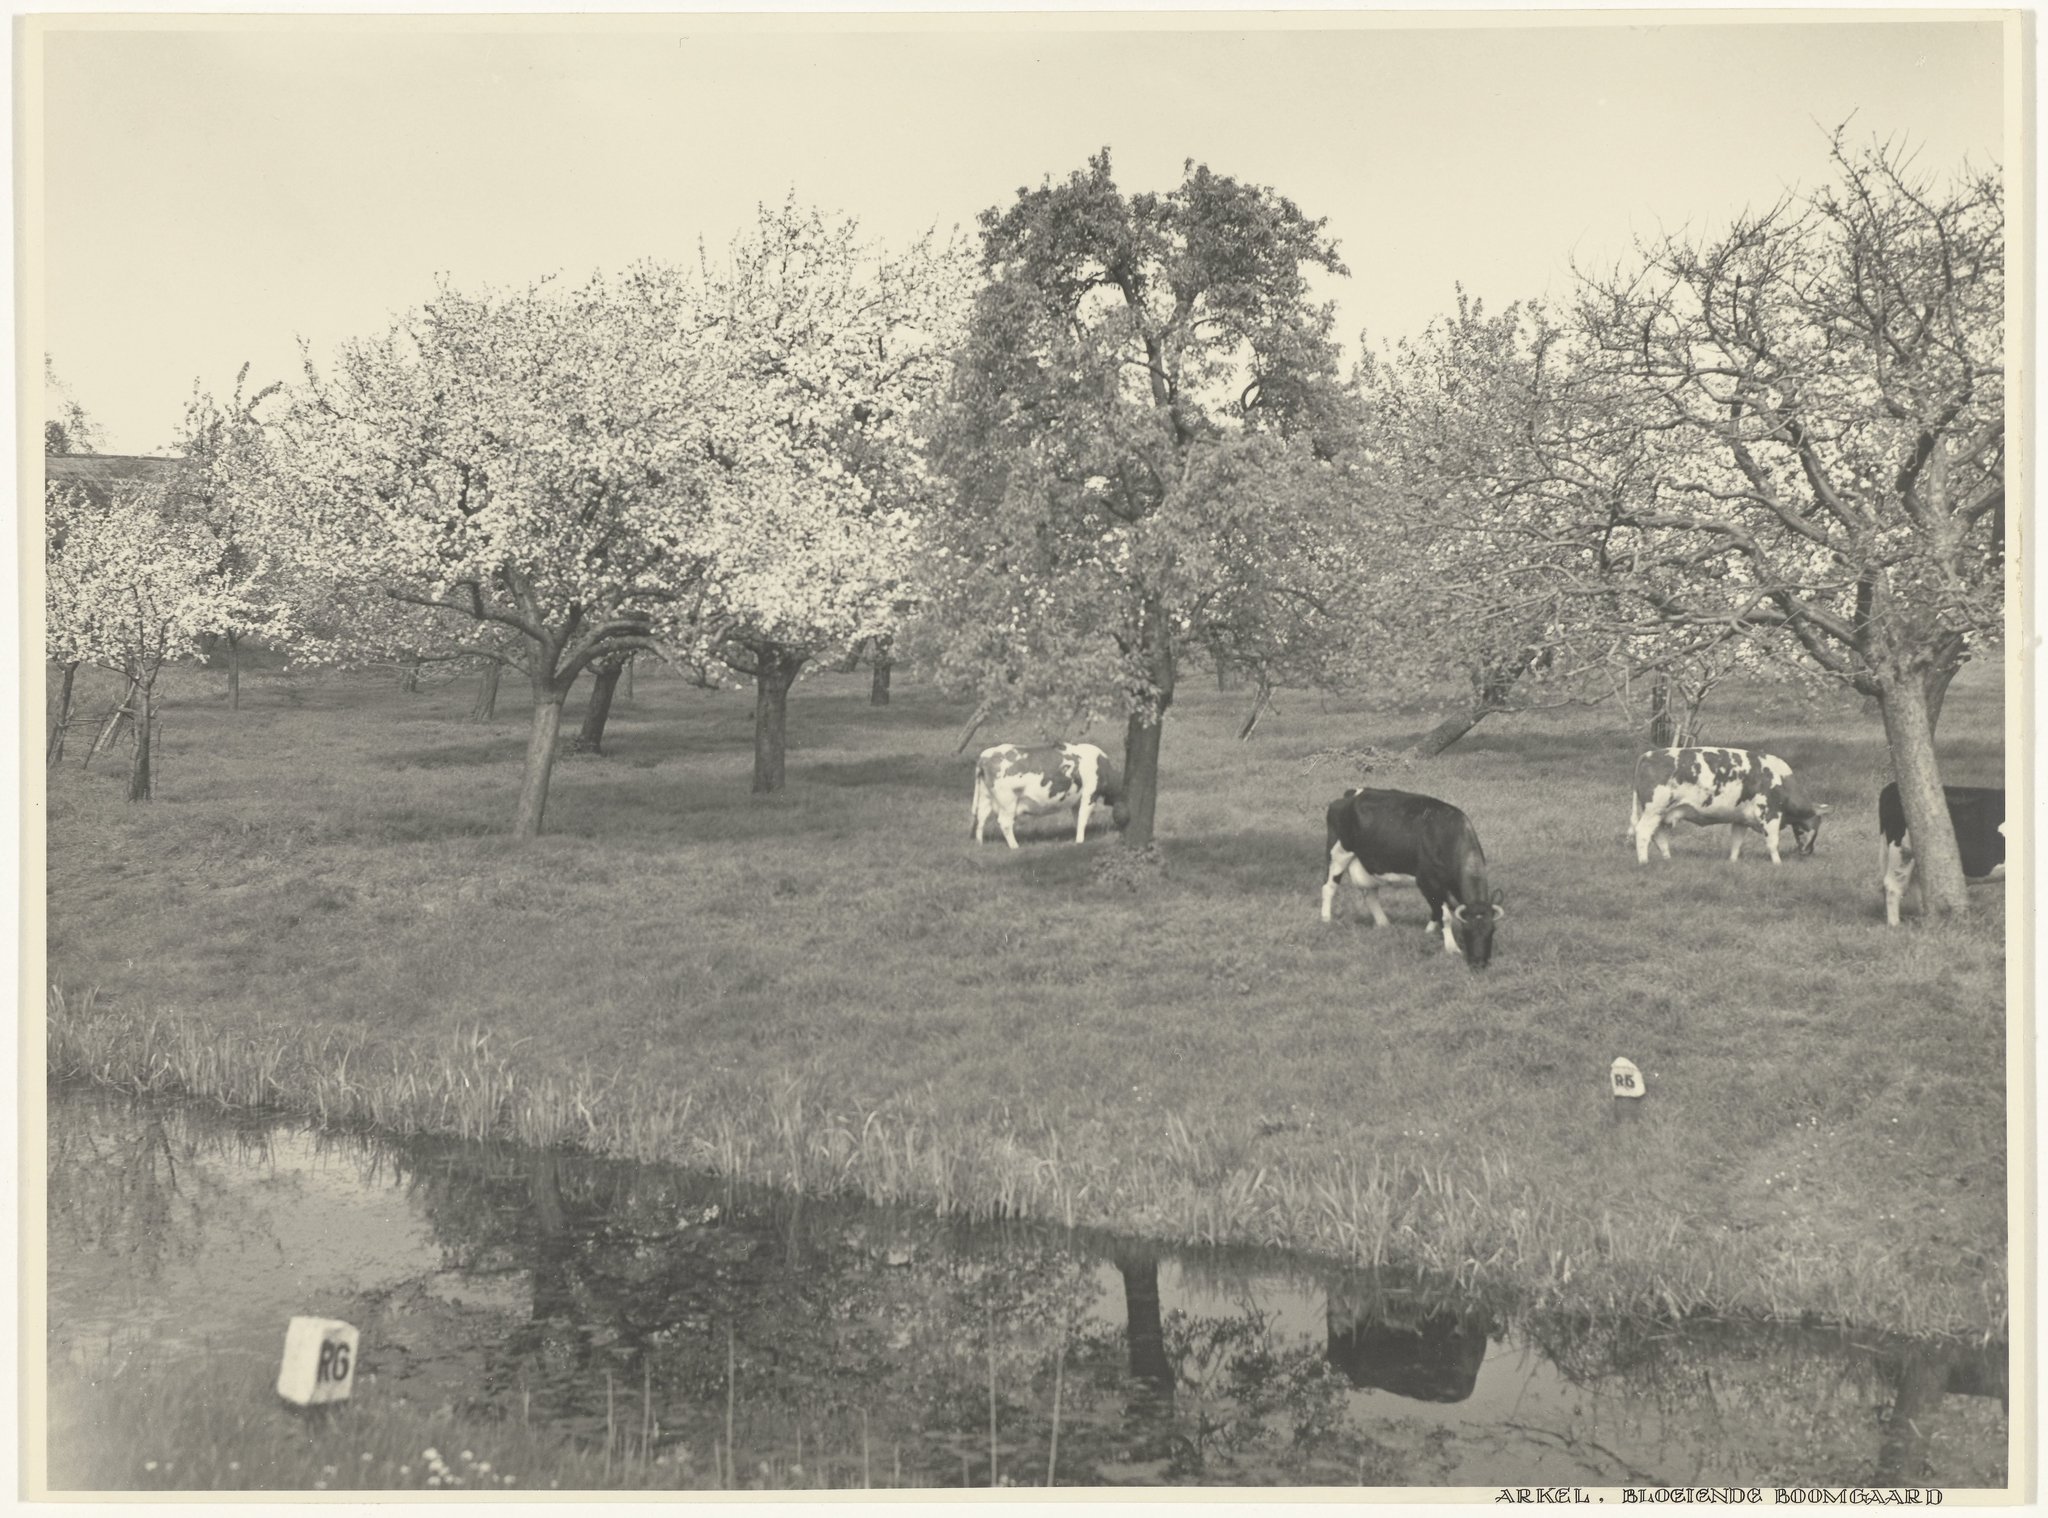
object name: photograph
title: Bloeiende boomgaard met grazende koeien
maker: Anonymous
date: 1920-1940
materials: cardboard, paper, photographic support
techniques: gelatin silver print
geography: netherlands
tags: cow, orchard